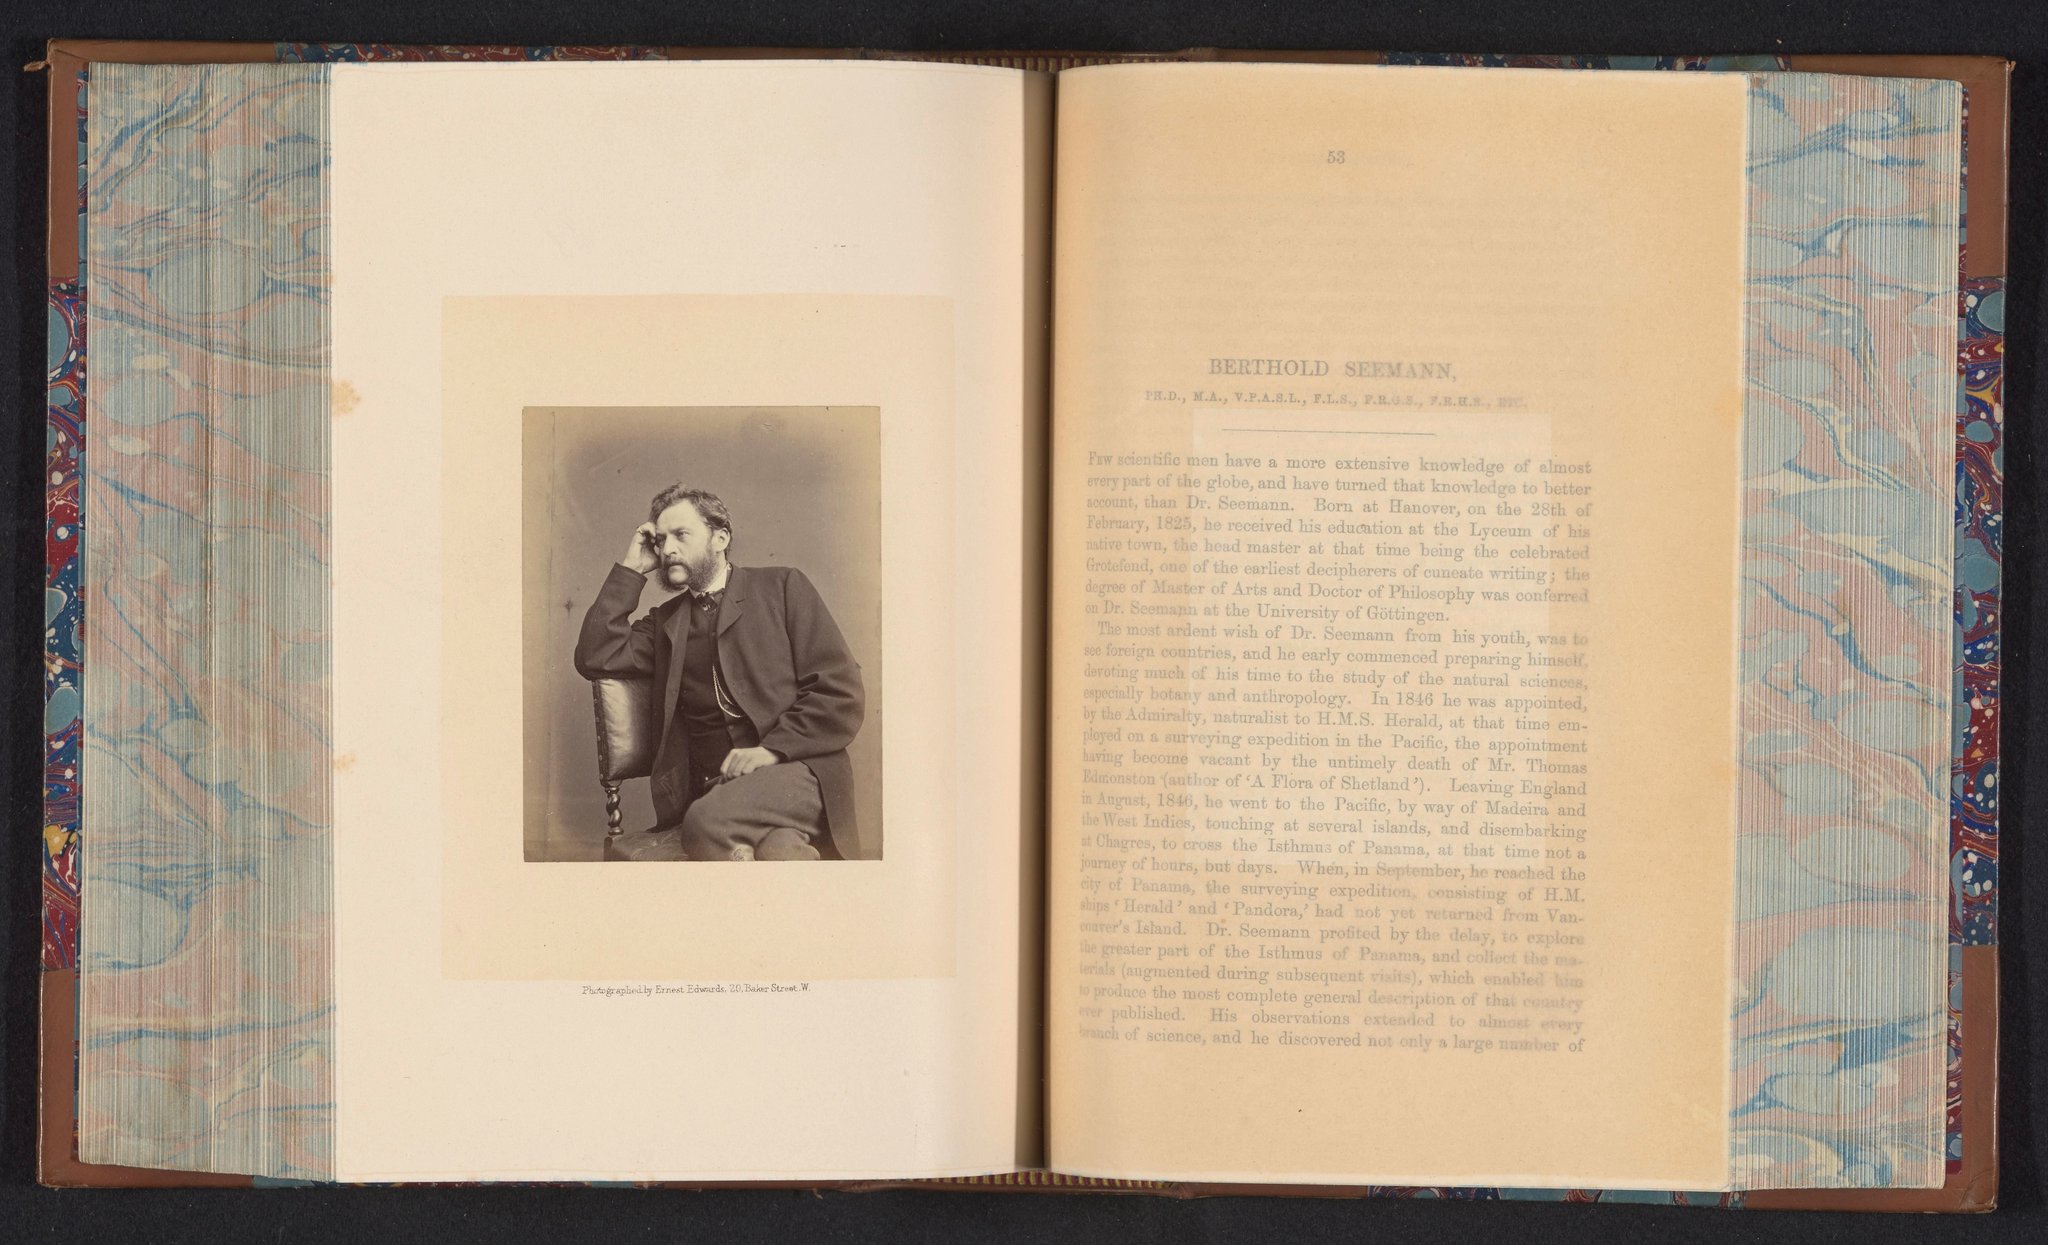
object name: photograph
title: Portret van Berthold Carl Seemann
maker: ernest edwards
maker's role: fotograaf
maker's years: 1837-1903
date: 1856-1866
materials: photographic support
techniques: albumen print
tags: adult man, historical persons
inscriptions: name: ‘Photographed by Ernest Edwards, 20, Baker Street. W.’